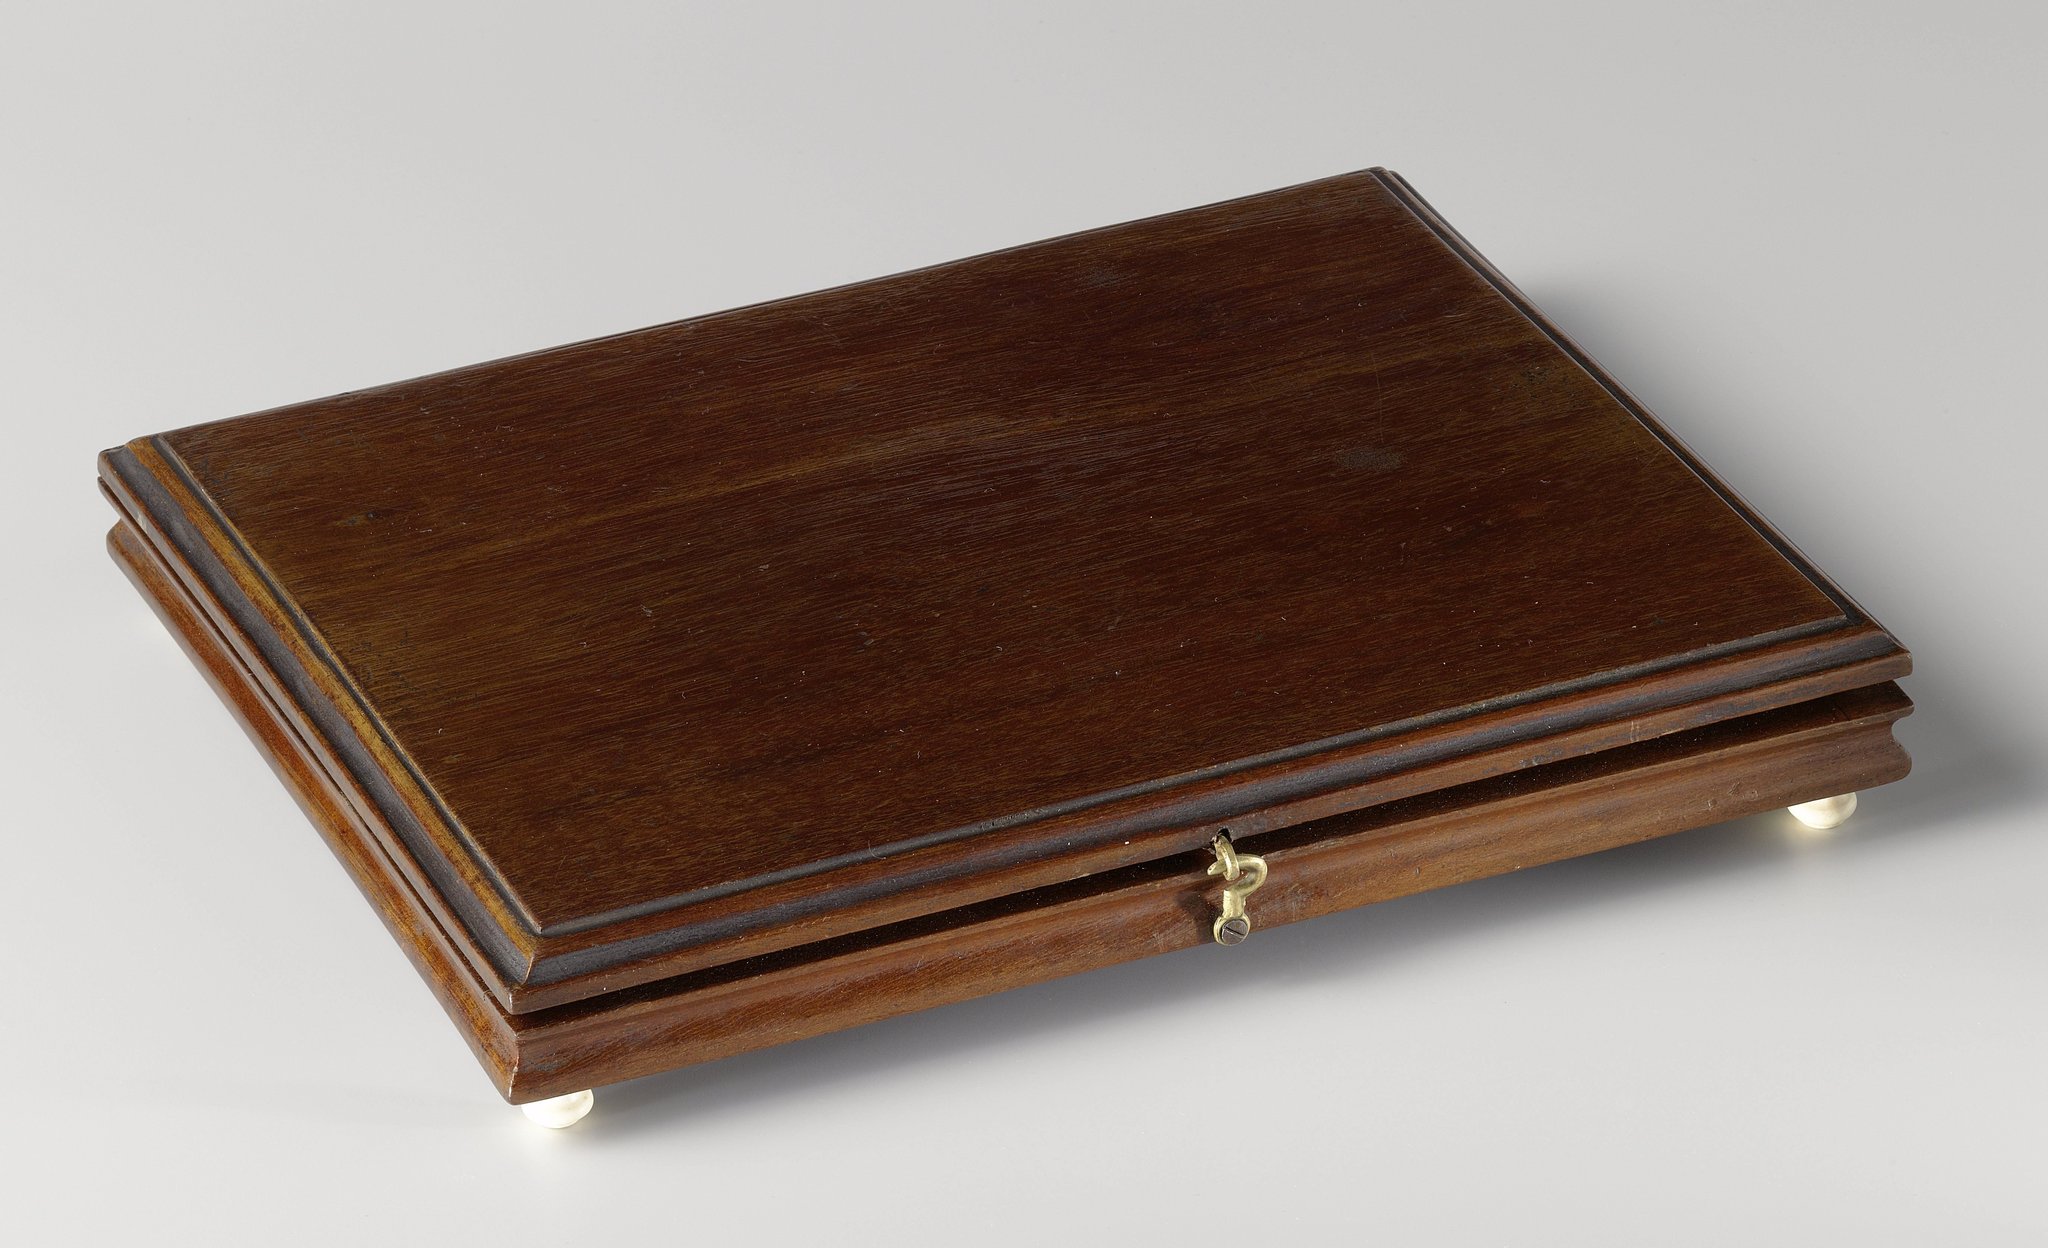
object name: domino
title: Box with a set of dominoes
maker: Anonymous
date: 1600-1625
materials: bone, wood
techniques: cutting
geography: flanders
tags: flushing, michiel adriaenszoon de ruyter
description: 28 dominostenen, met op elke steen de afbeelding van een figuur. Afgebeeld zijn de vier temperamenten, man-, vrouwfiguren, narren en andere allegorische figuren. Een sortering van de stenen in numerieke volgorde geeft niet de volgorde van eerdergenoemde groepen figuren. De stenen zitten in een houten kistje met klapdeksel. Het kistje staat op vier ronde benen knopjes. De binnenzijde van de doos is met marmerpapier beplakt.